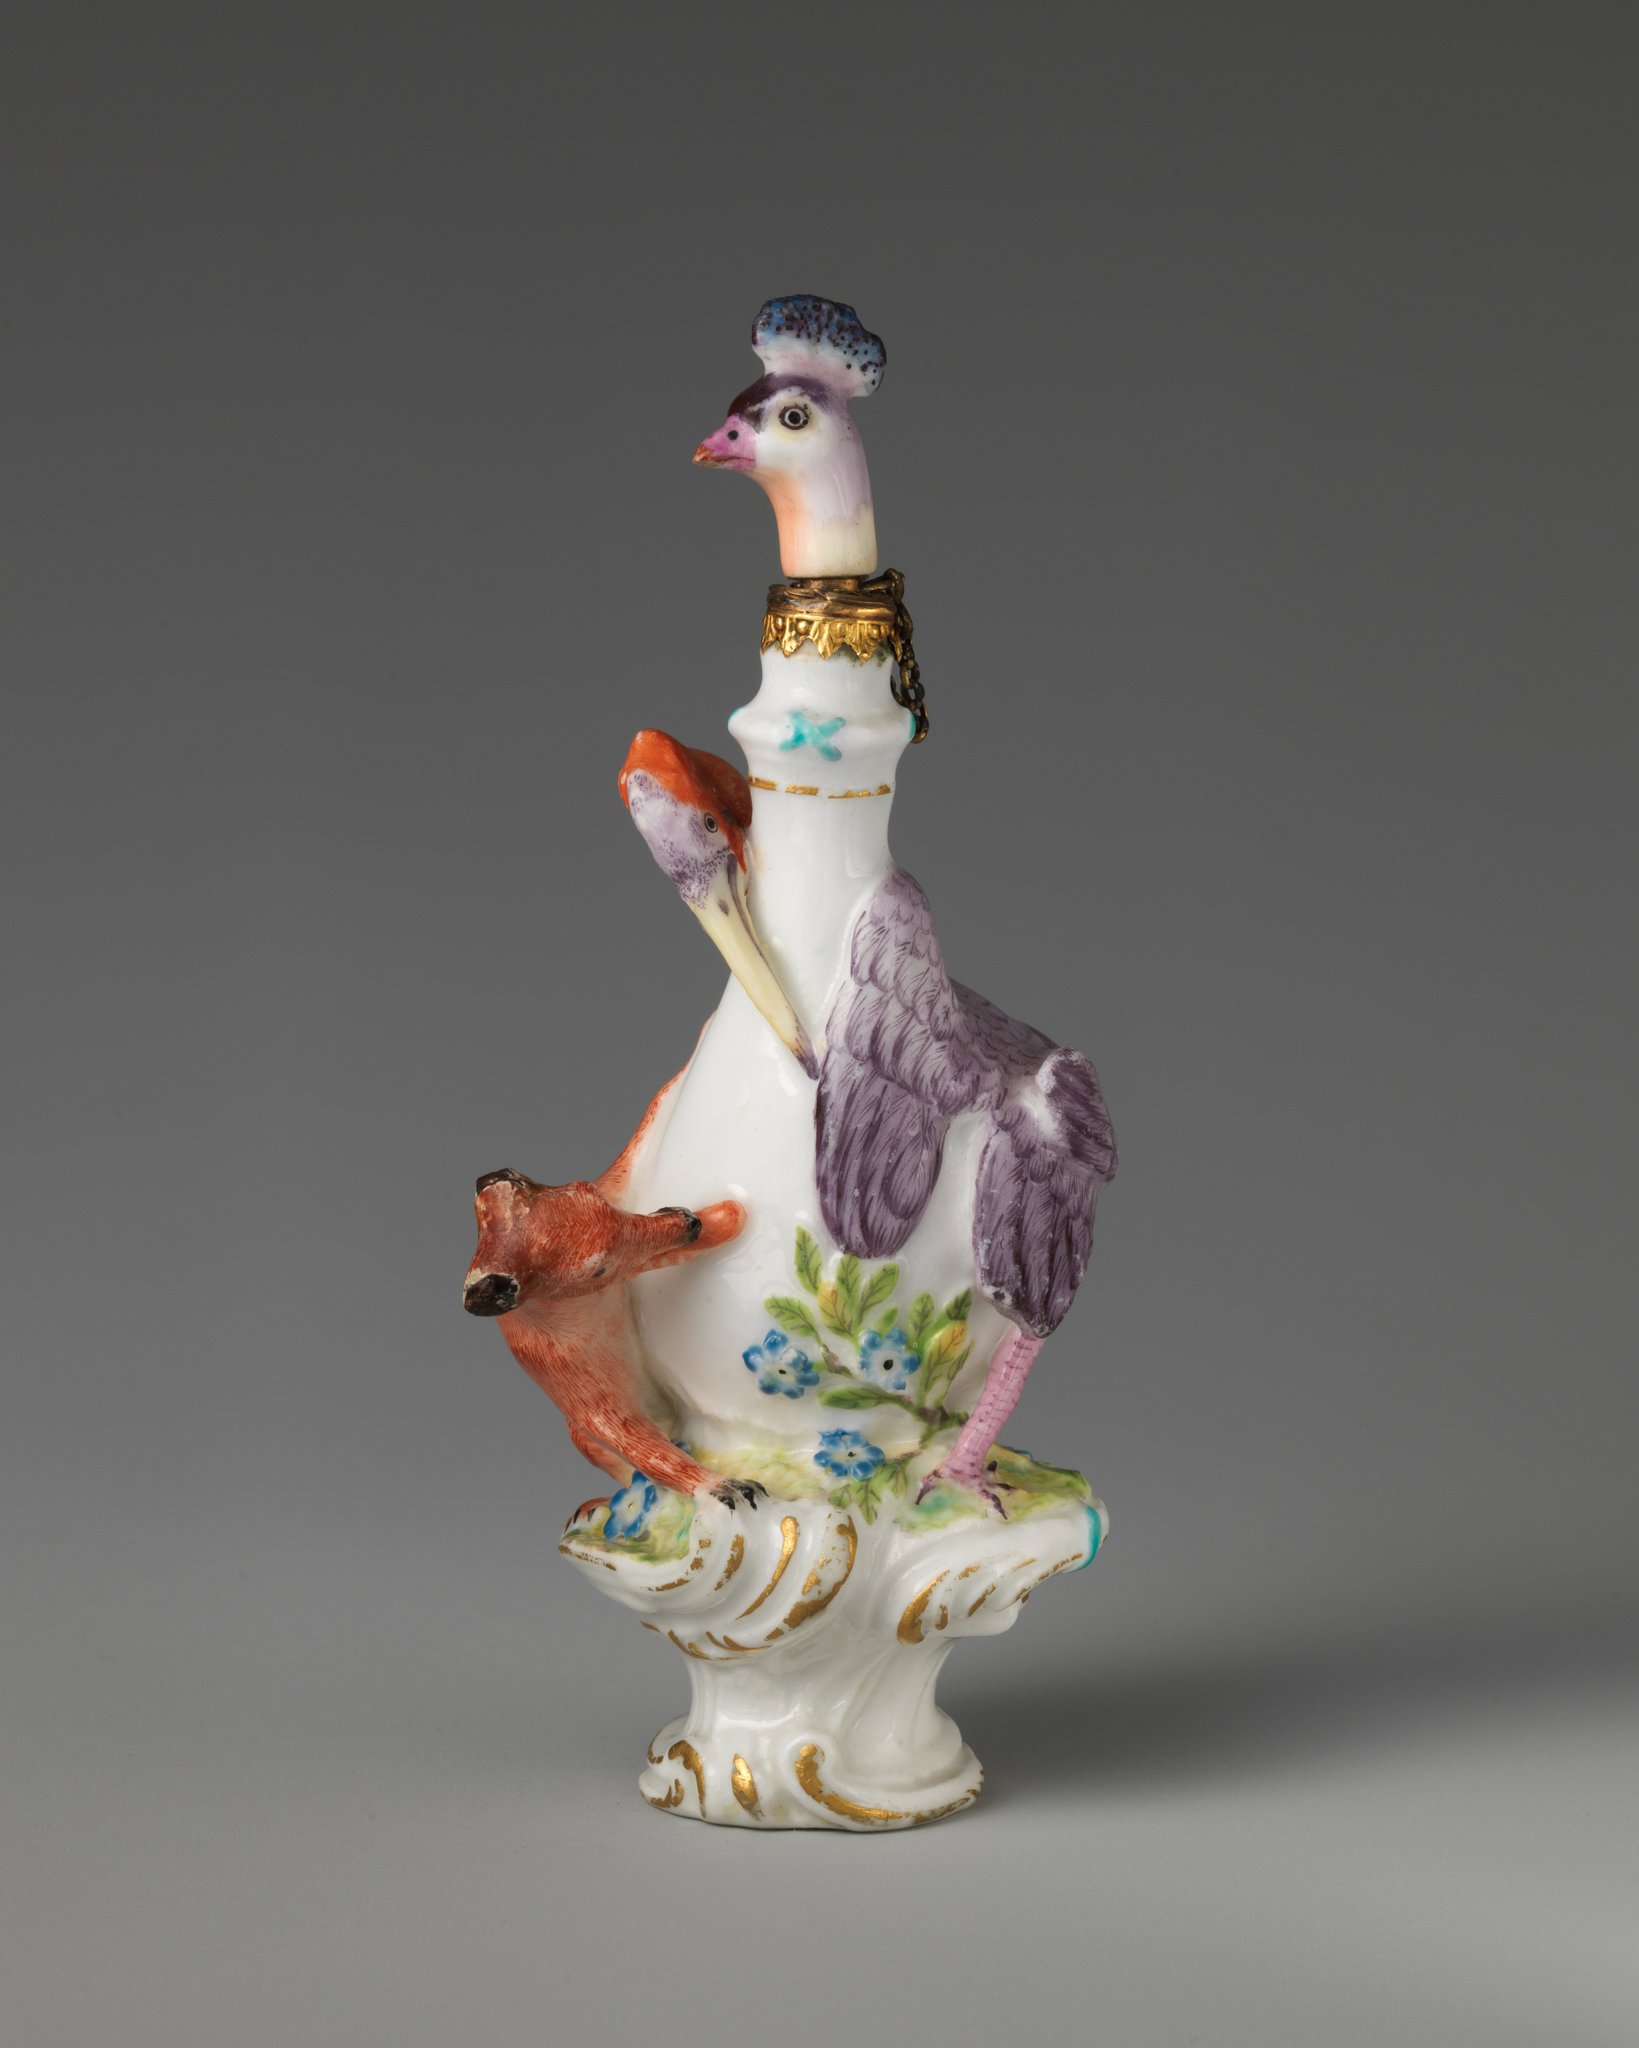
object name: toy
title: Fox and stork in a group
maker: chelsea porcelain manufactory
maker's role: factory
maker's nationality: british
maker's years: 1744-1784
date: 1753-1758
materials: soft paste porcelain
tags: birds,foxes